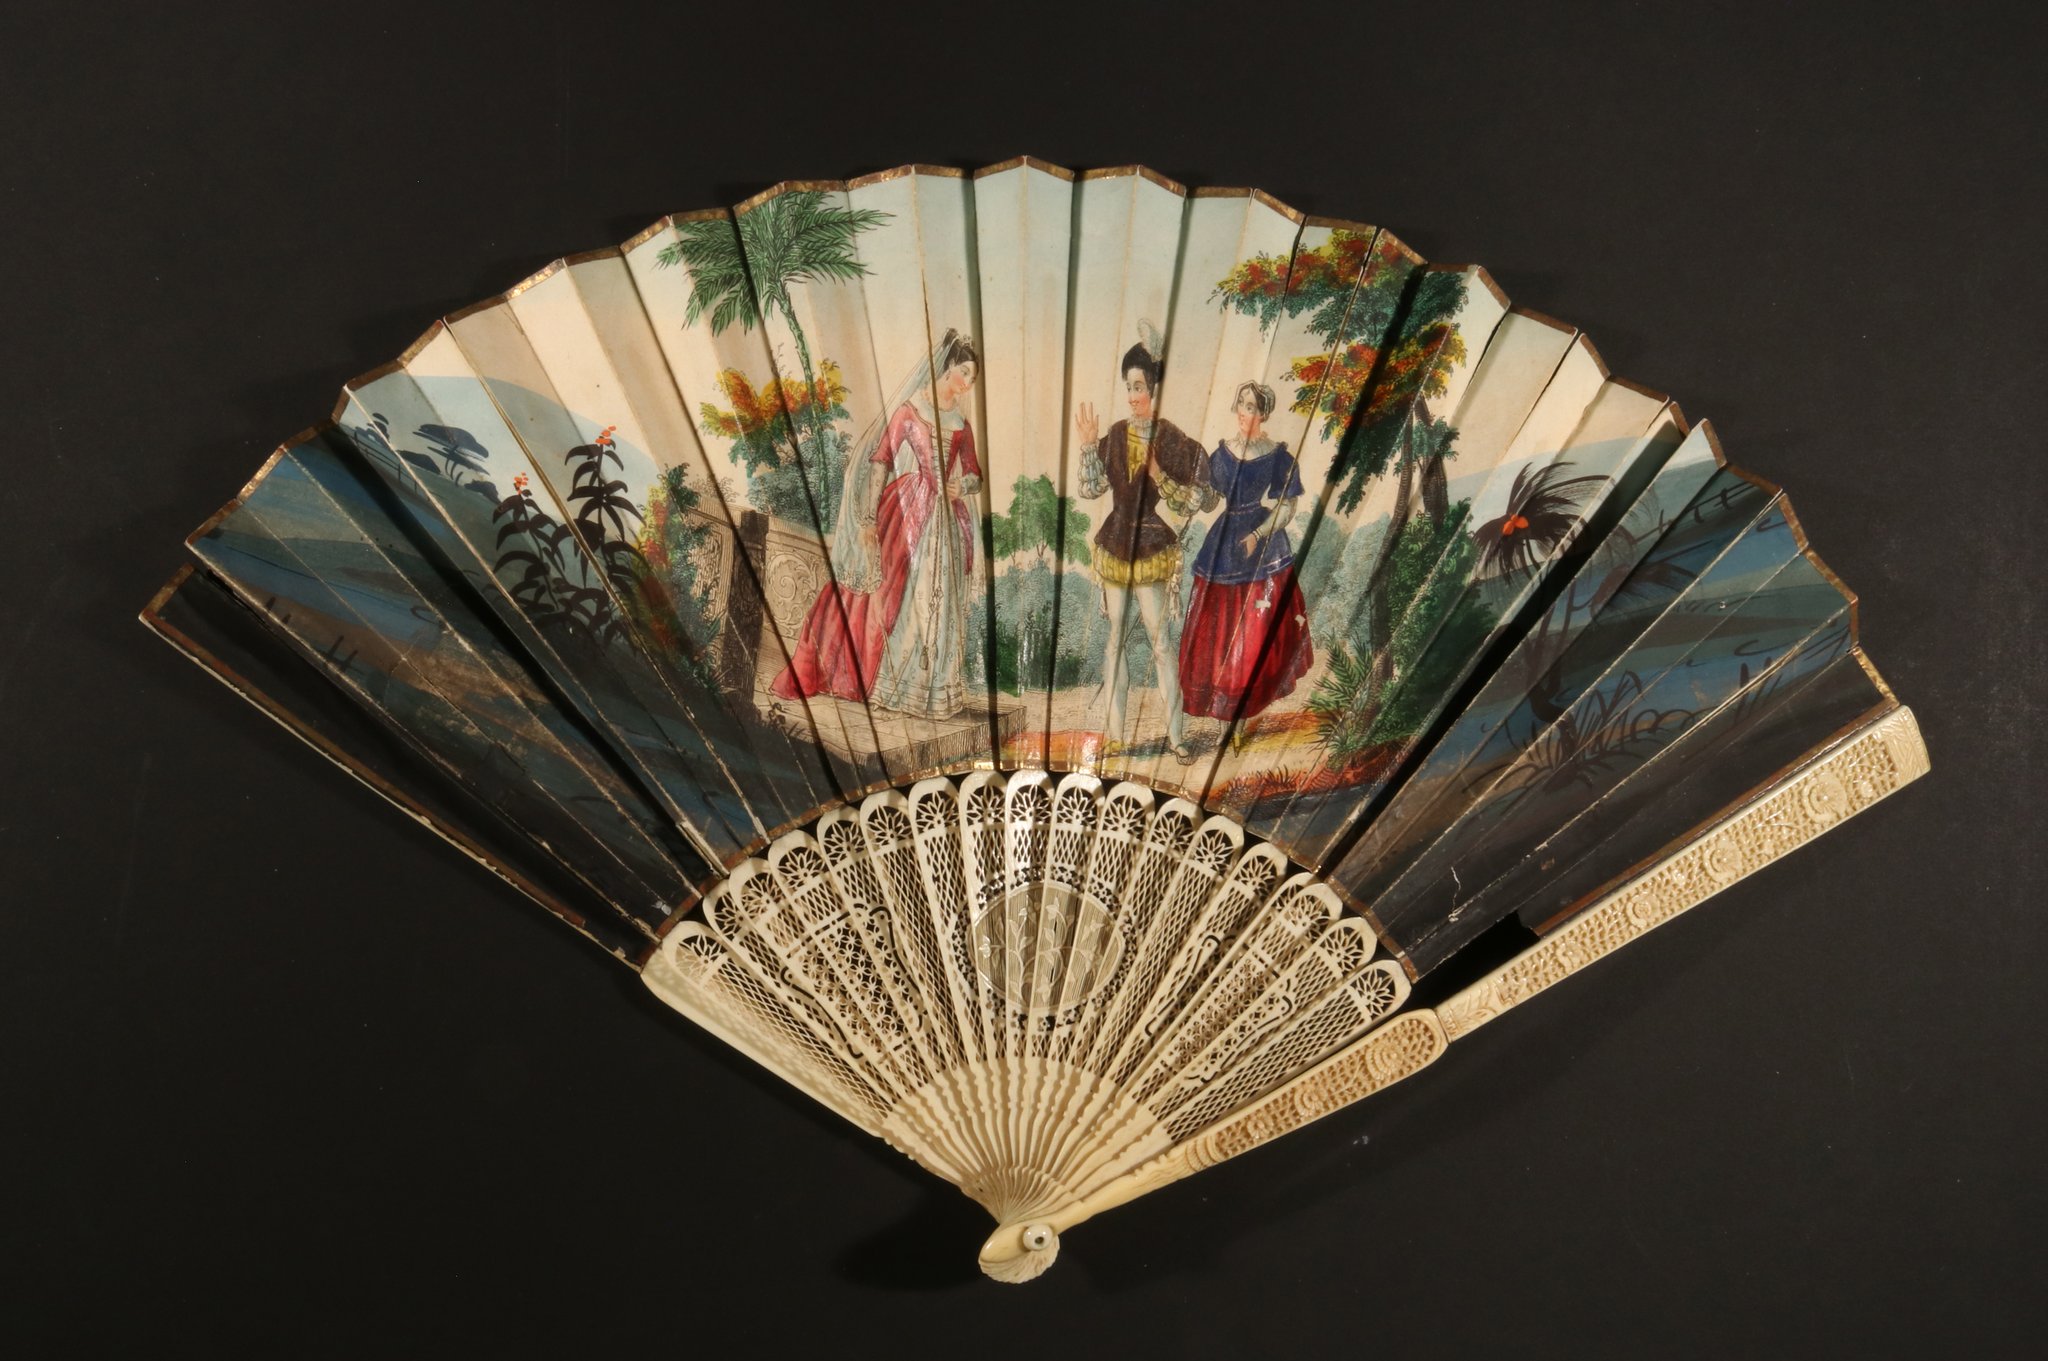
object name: fan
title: Folding Fan with Scene of Figures in a Landscape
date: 1830-1840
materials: ivory, paper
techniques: hand coloring, printing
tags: men,women